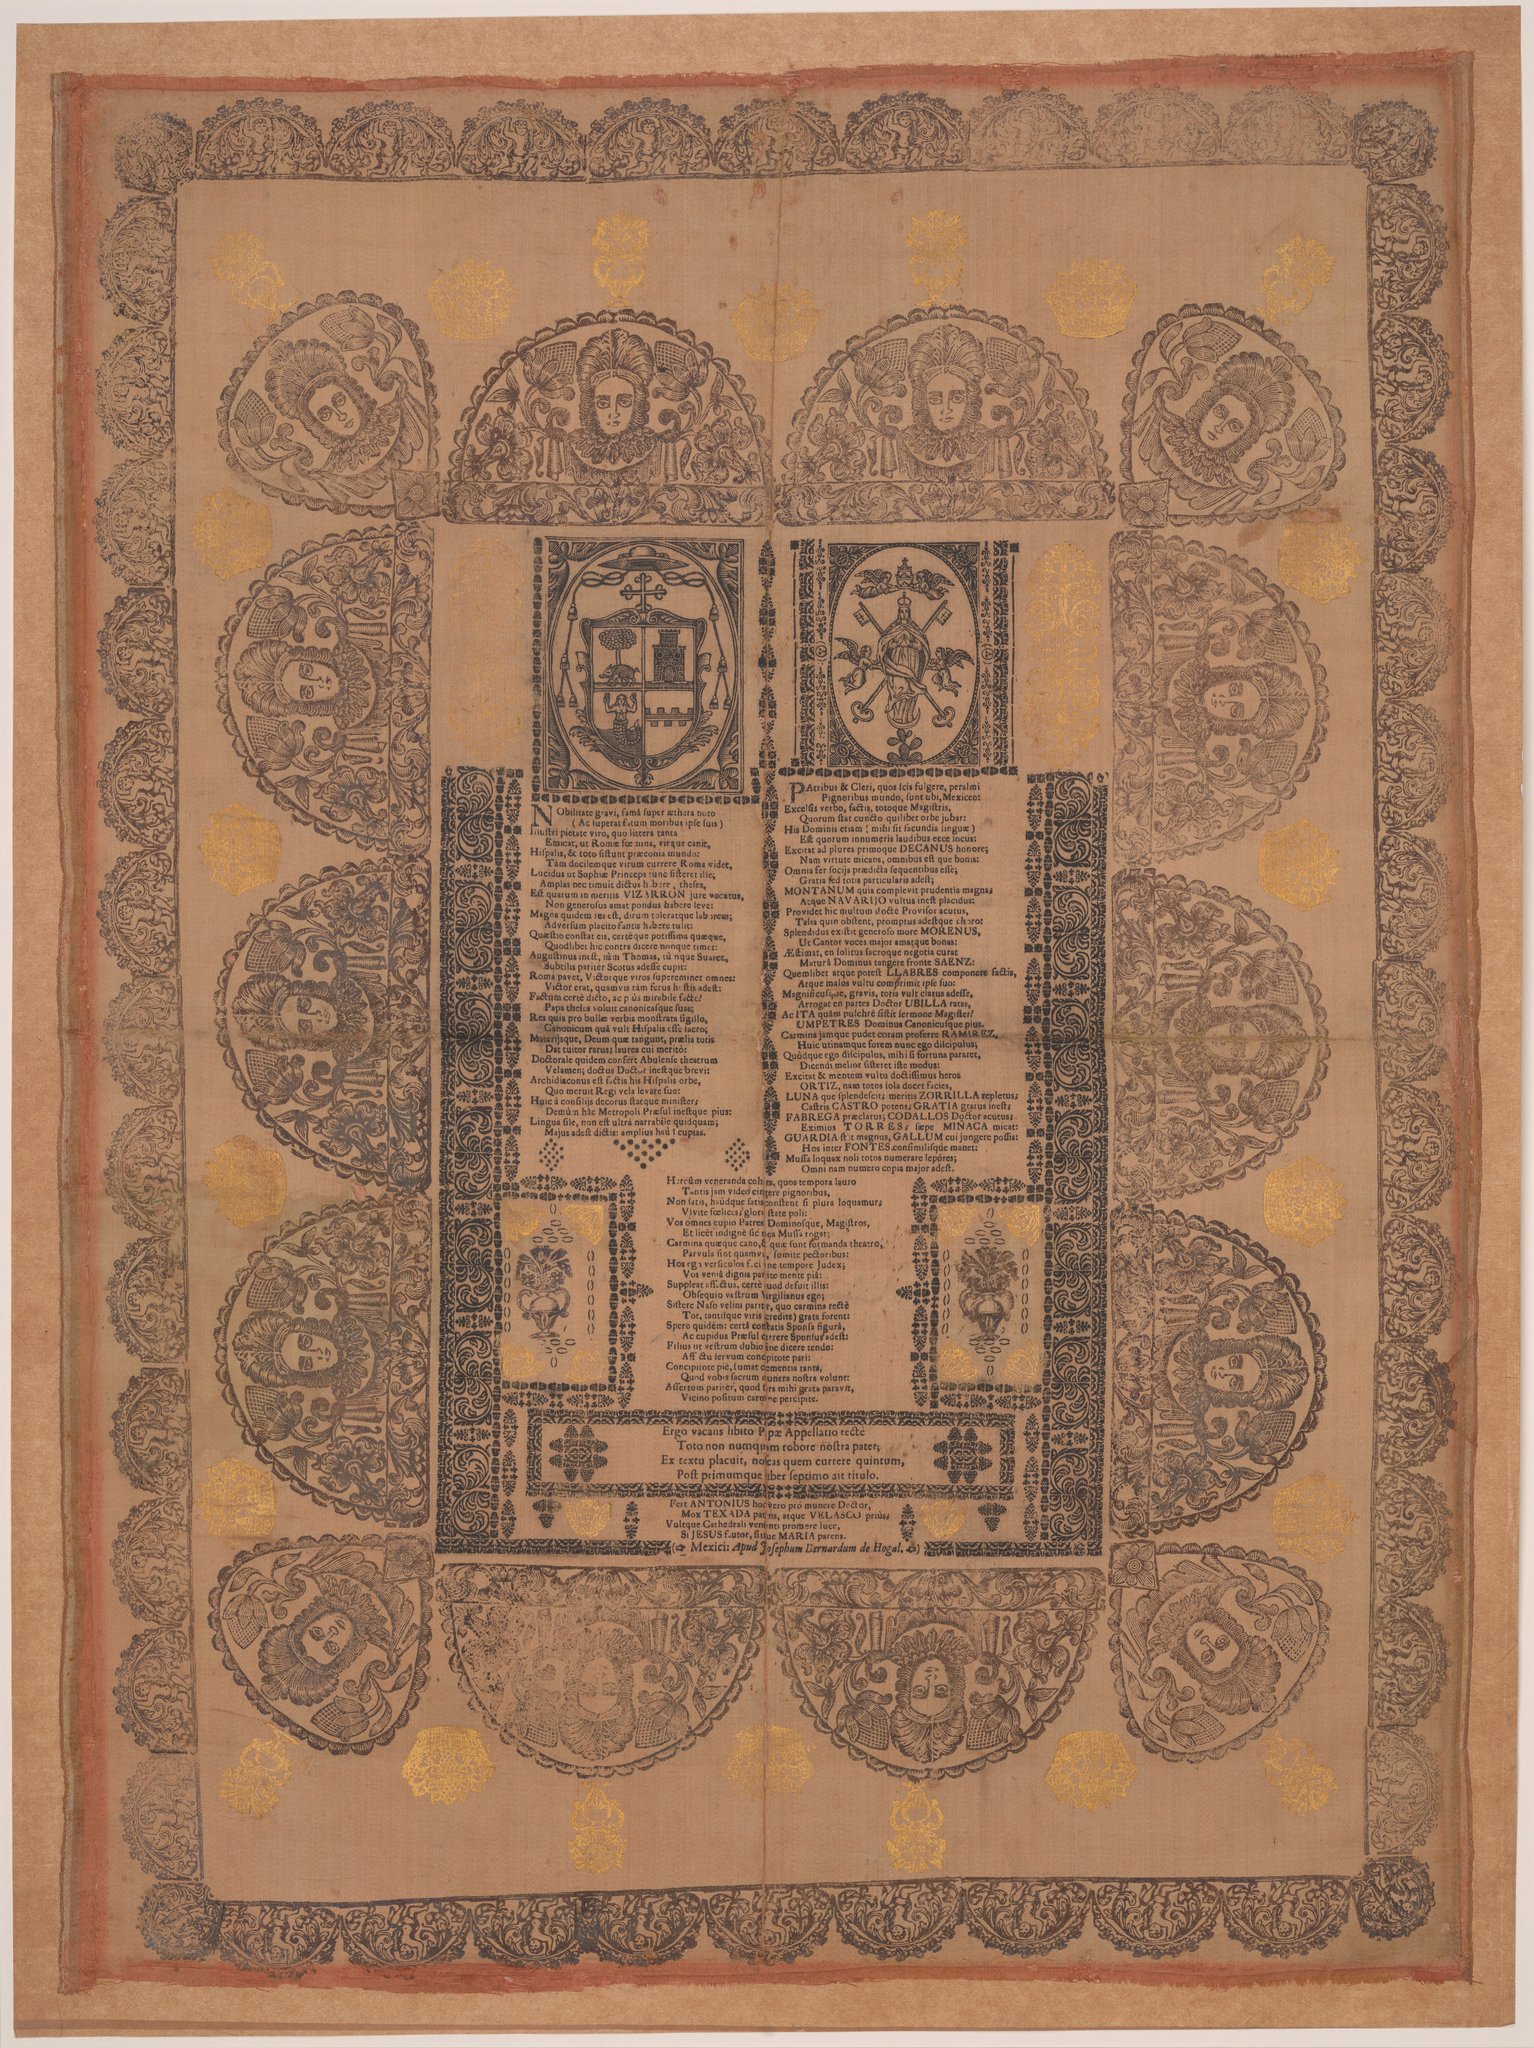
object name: print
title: Print dedicated to Juan Antonio Vizarrón y Eguiarreta, Archbishop of Mexico and Viceroy of New Spain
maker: juan antonio vizarrón y eguiarreta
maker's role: dedicatee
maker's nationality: spanish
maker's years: 1682-1747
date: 1730-1740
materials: silk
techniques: printing, woodcut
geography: mexico